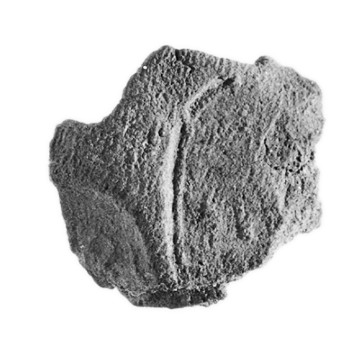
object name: sealing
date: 1981-1640 BCE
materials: mud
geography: egypt